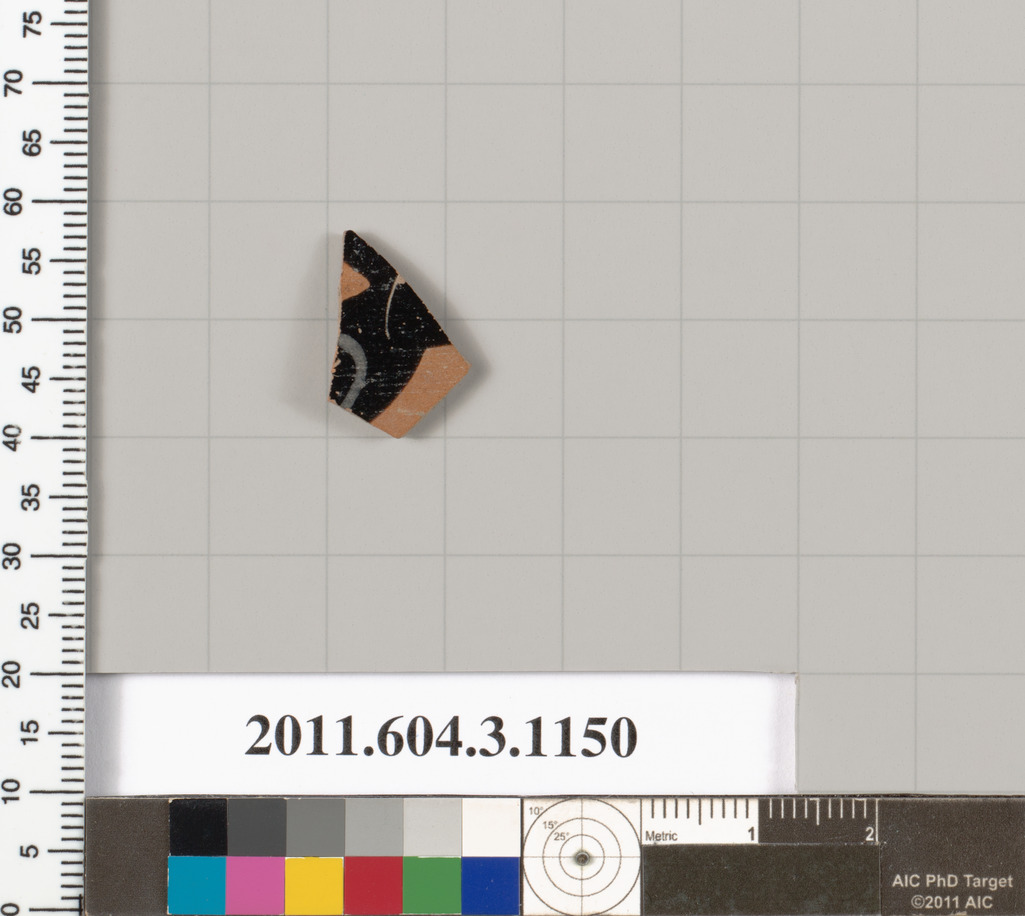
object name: mastoid or kyathos fragment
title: Terracotta fragment of a mastoid (drinking cup with narrow base) or a kyathos (cup-shaped ladle)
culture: greek, attic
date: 534-468 BCE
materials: terracotta